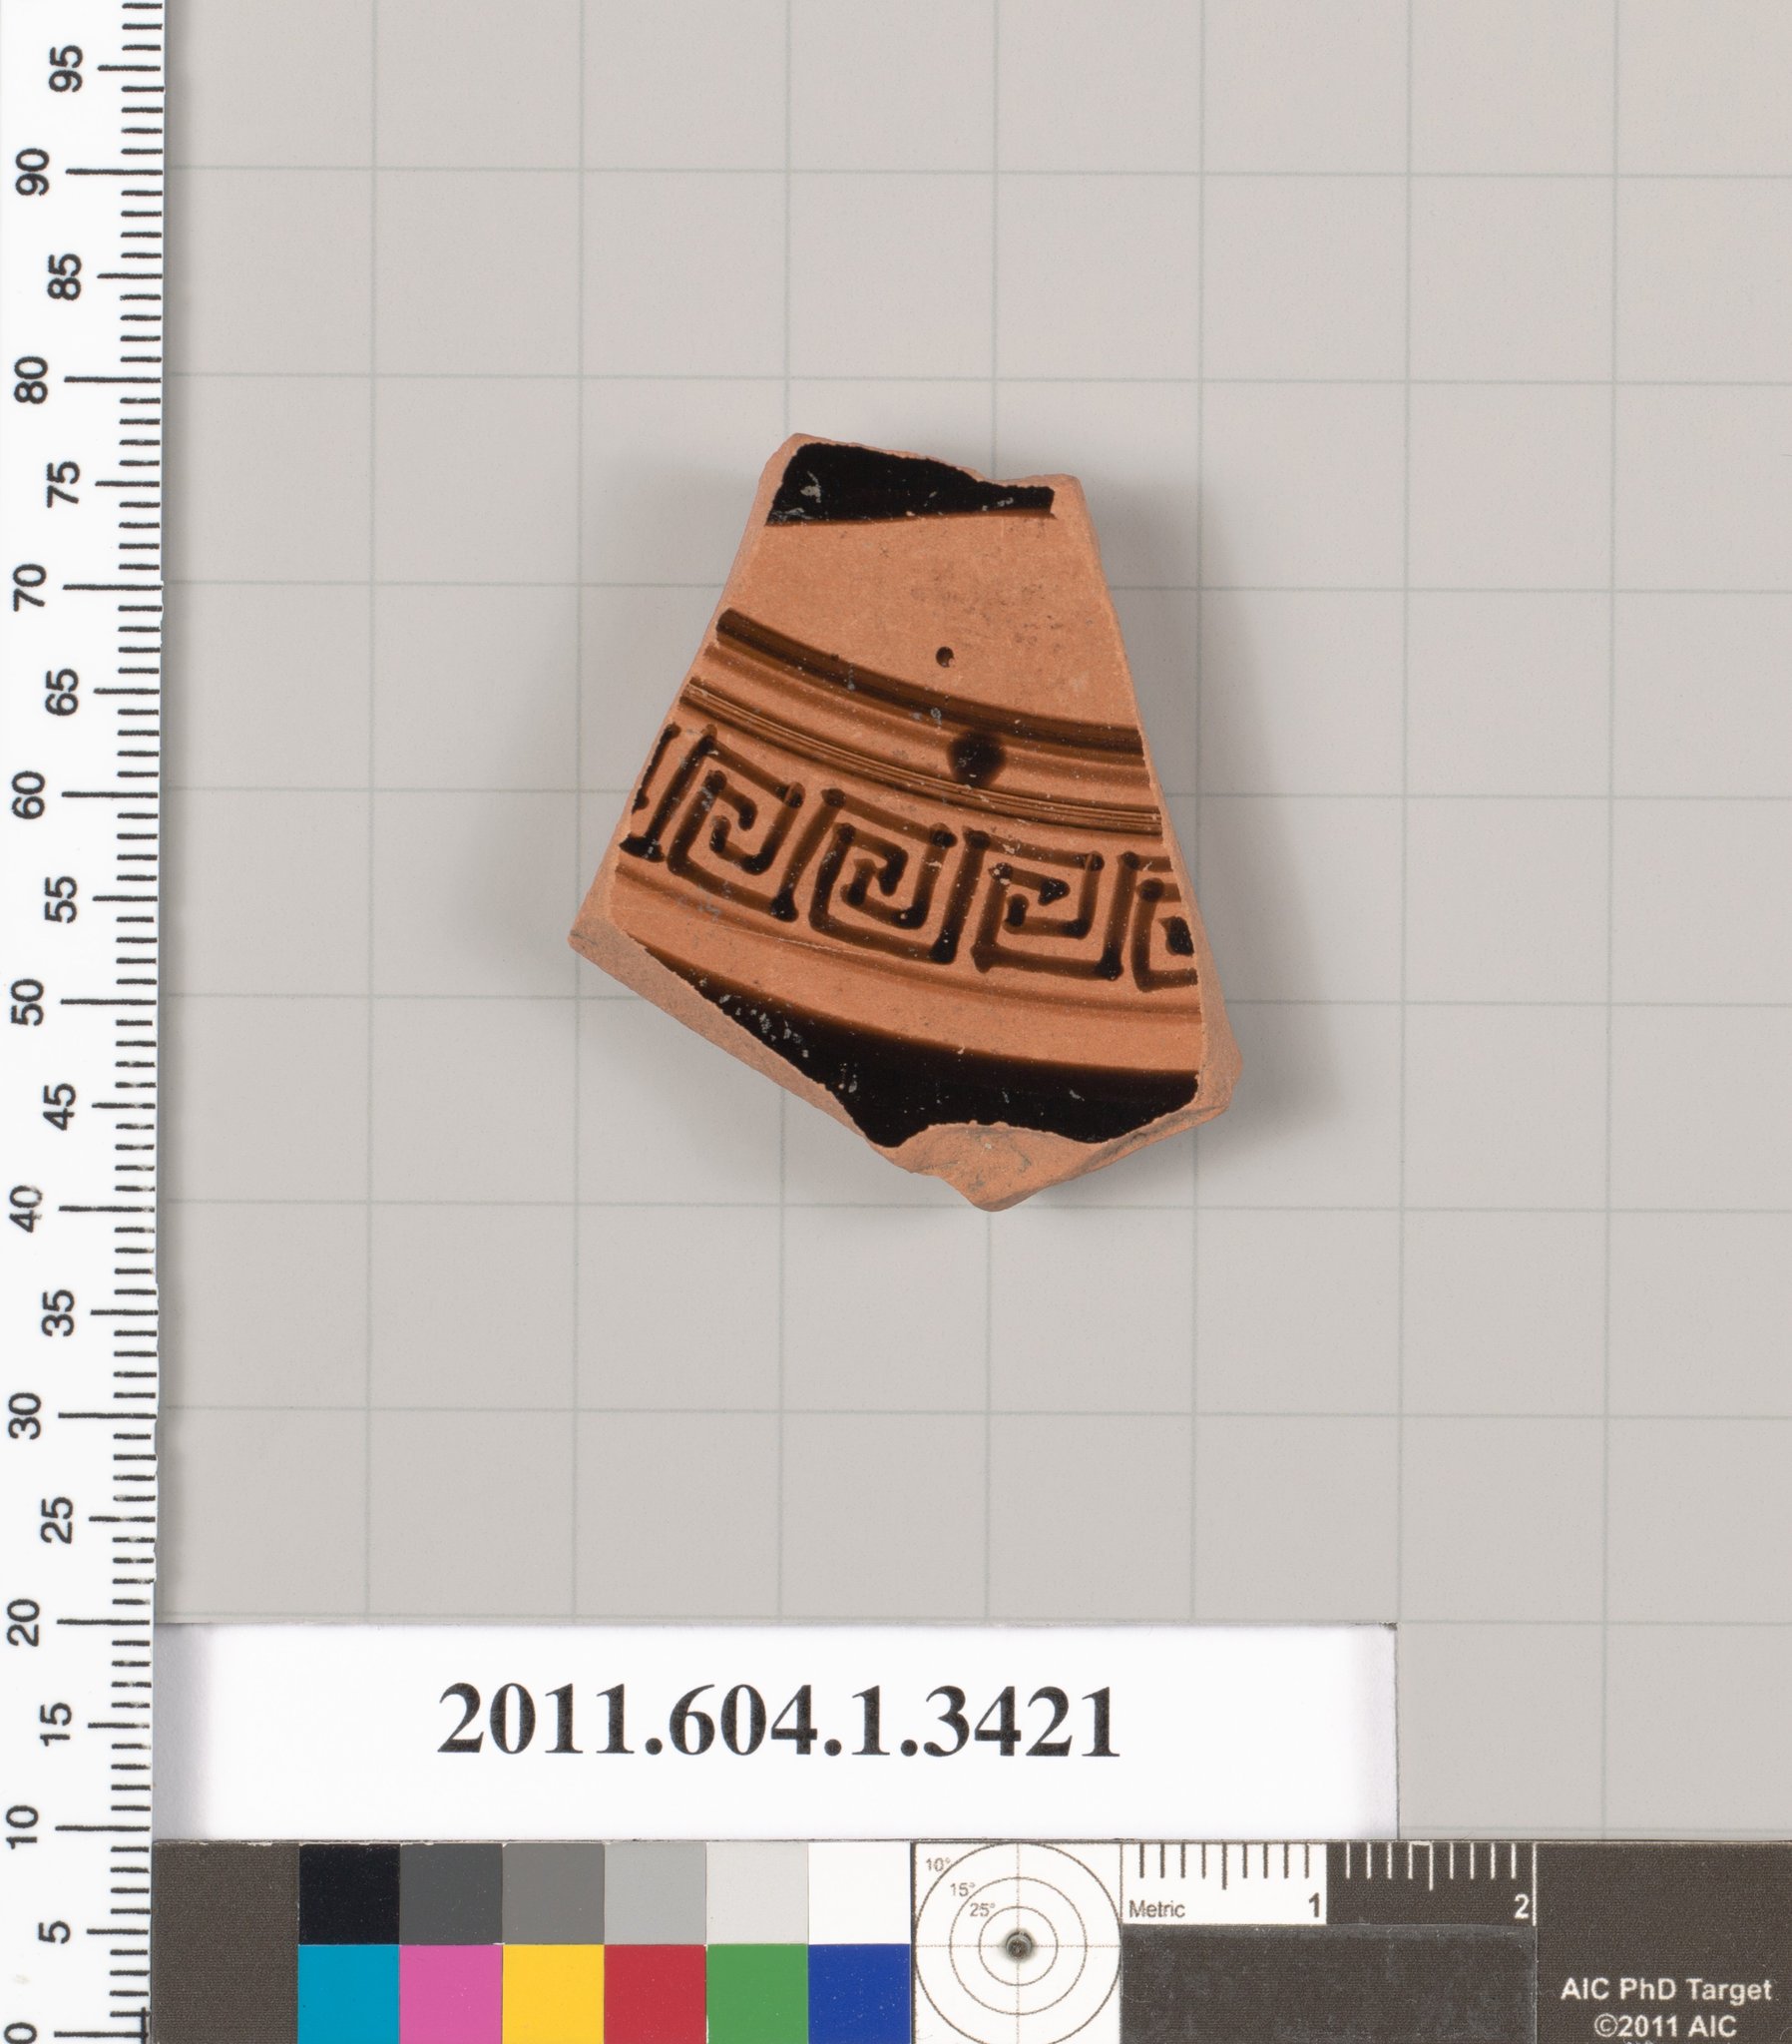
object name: kylix fragment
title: Terracotta fragment of a kylix (drinking cup)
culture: greek, attic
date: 490-470 BCE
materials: terracotta